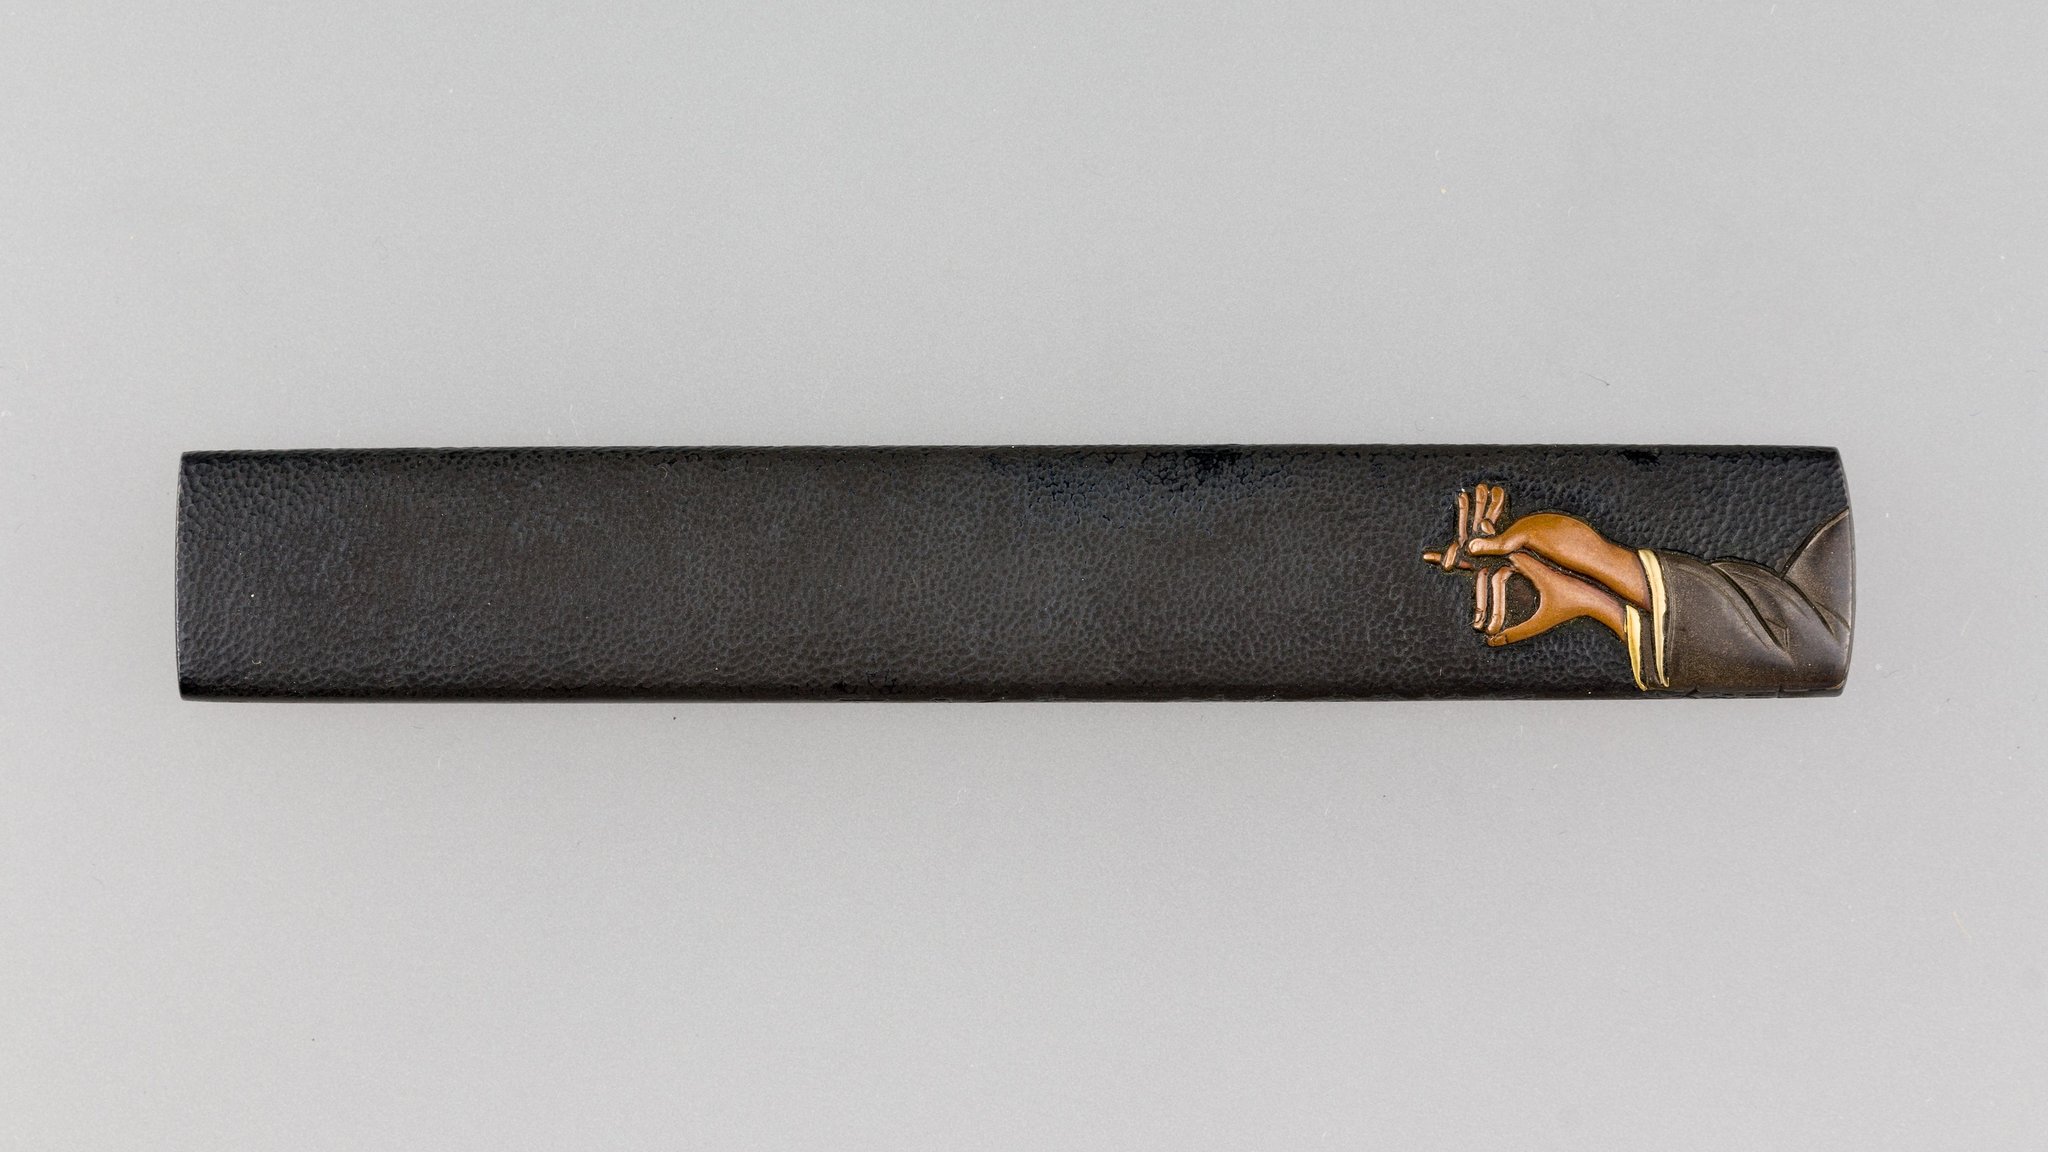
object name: knife handle kozuka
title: Knife Handle (Kozuka)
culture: japanese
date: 1751-1800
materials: copper, gold alloy, silver alloy, gold, silver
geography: japan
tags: hands